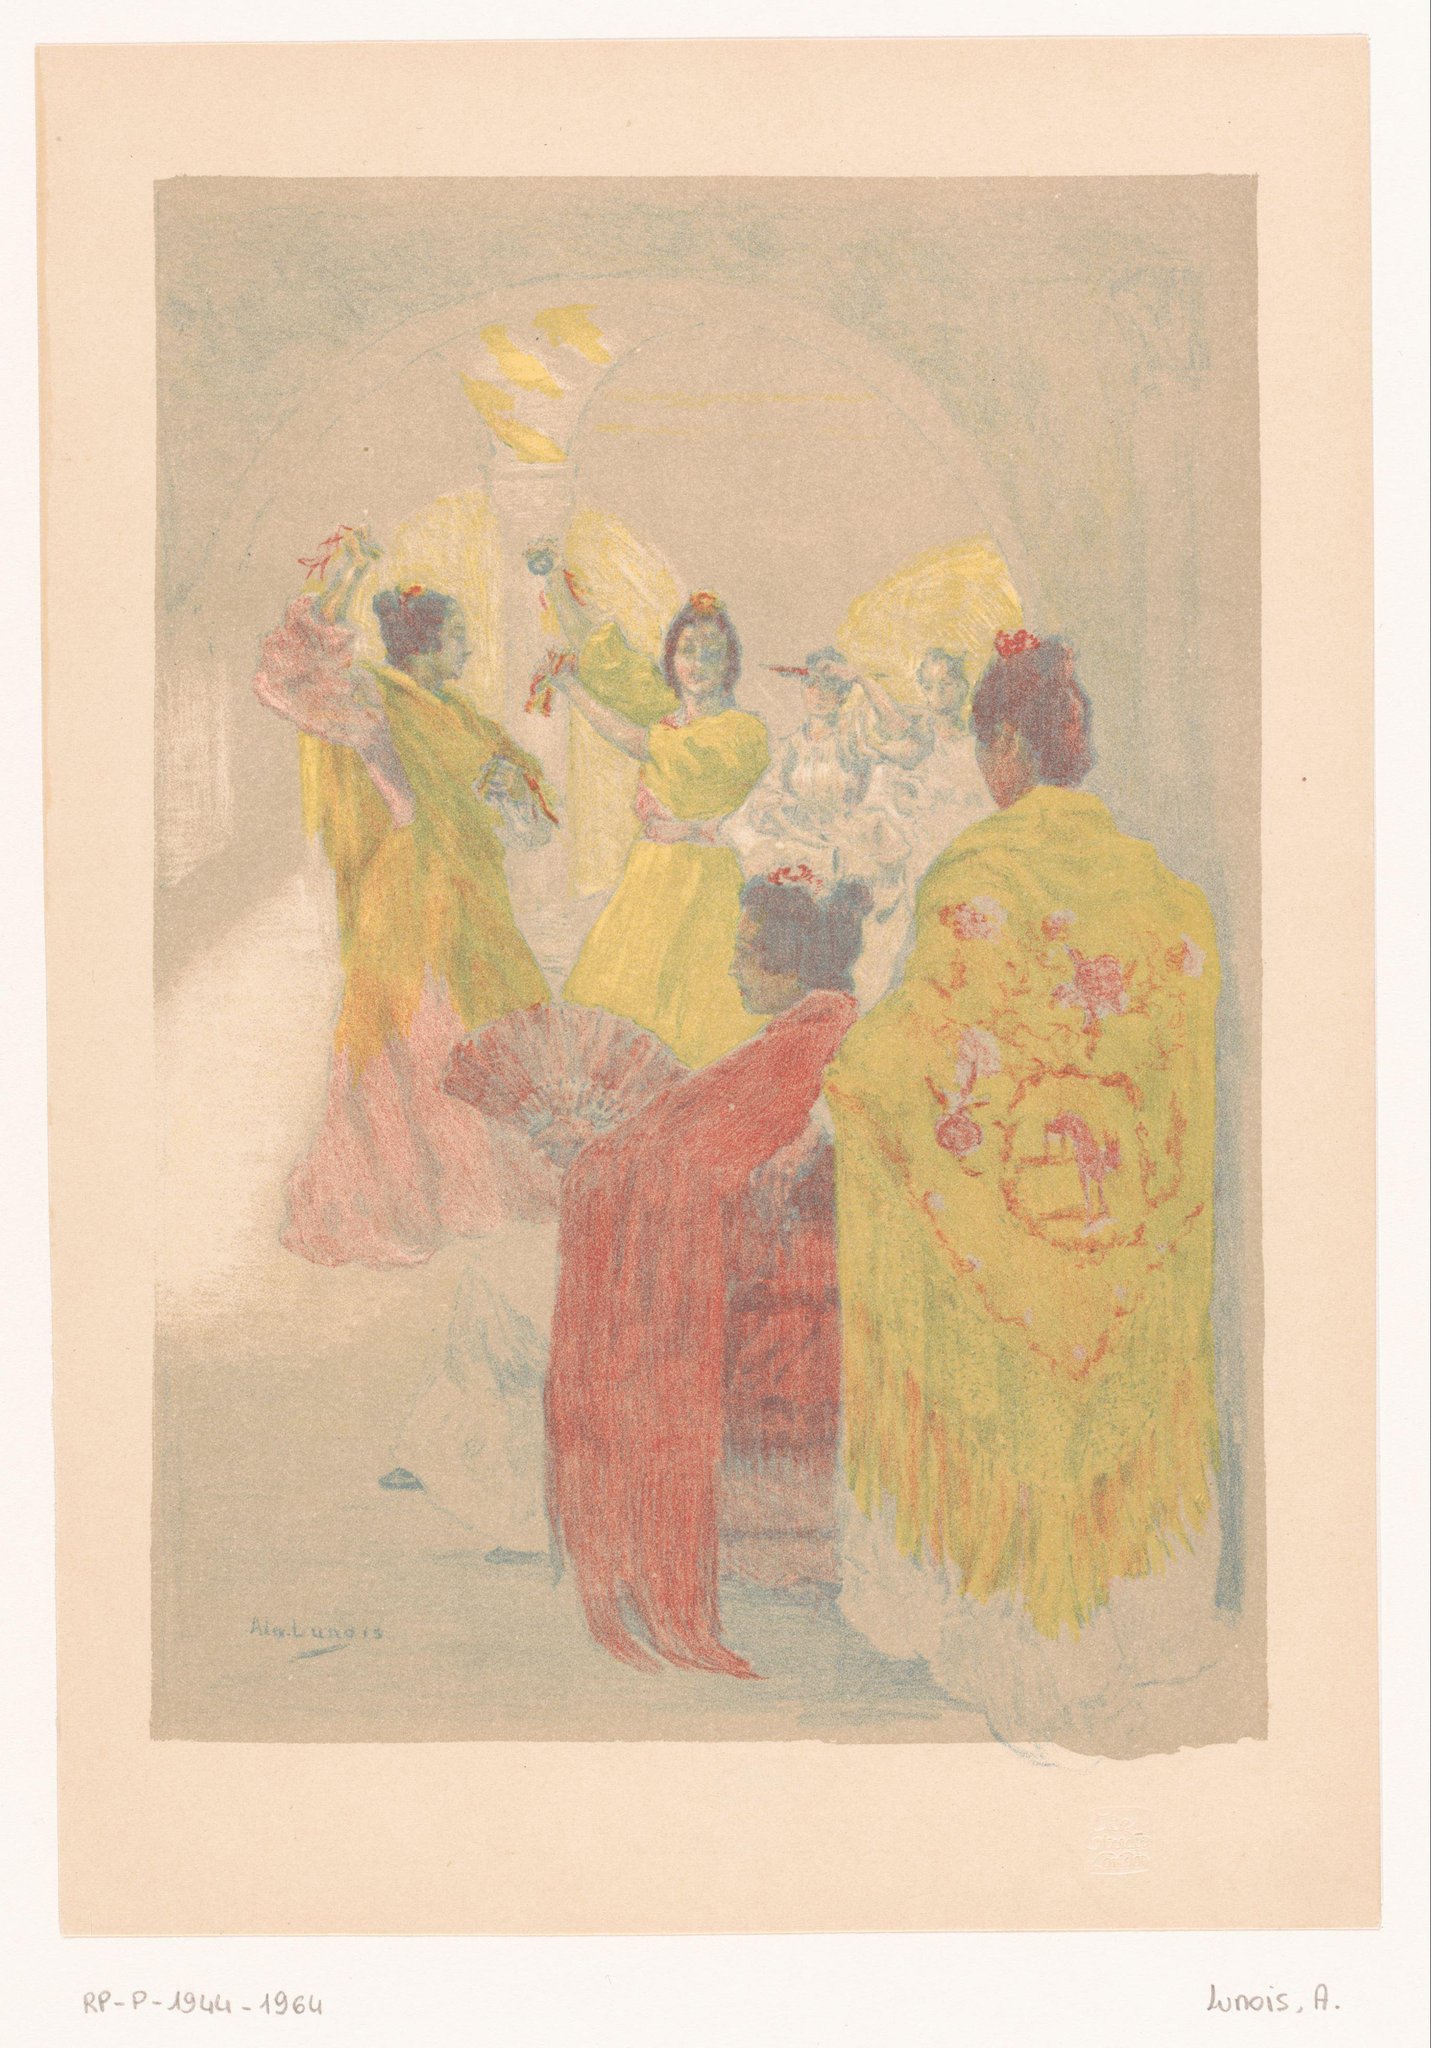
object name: print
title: La sevillana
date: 1897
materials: paper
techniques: lithograph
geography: london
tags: folk dancing (men and women together), fan, historical costume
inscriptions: check stamp: Lugt 2322bis, collector's mark: Lugt 2228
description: Prent gebruikt voor: The Studio: an illustrated magazine of fine and applied art 11 (1897), nr. 51, juni 1897, p. 38.